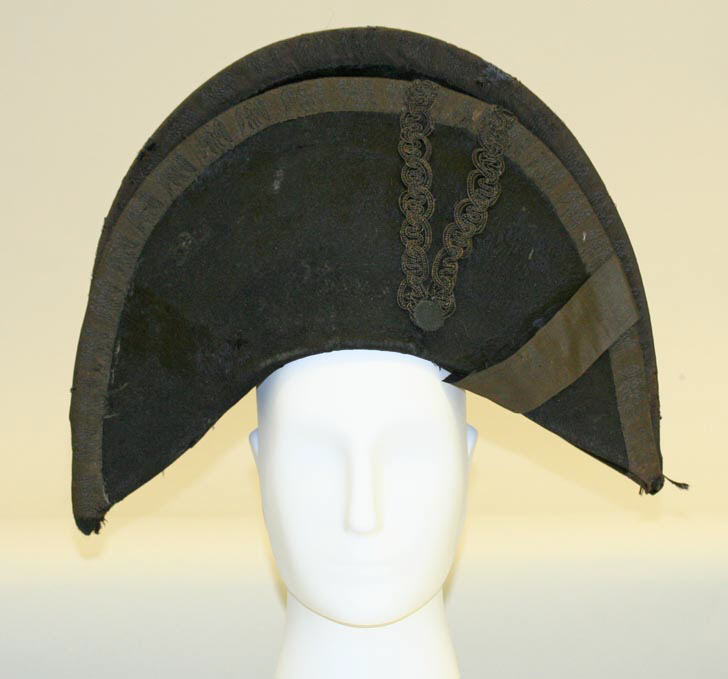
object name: bicorne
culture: american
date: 1790-1810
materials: silk